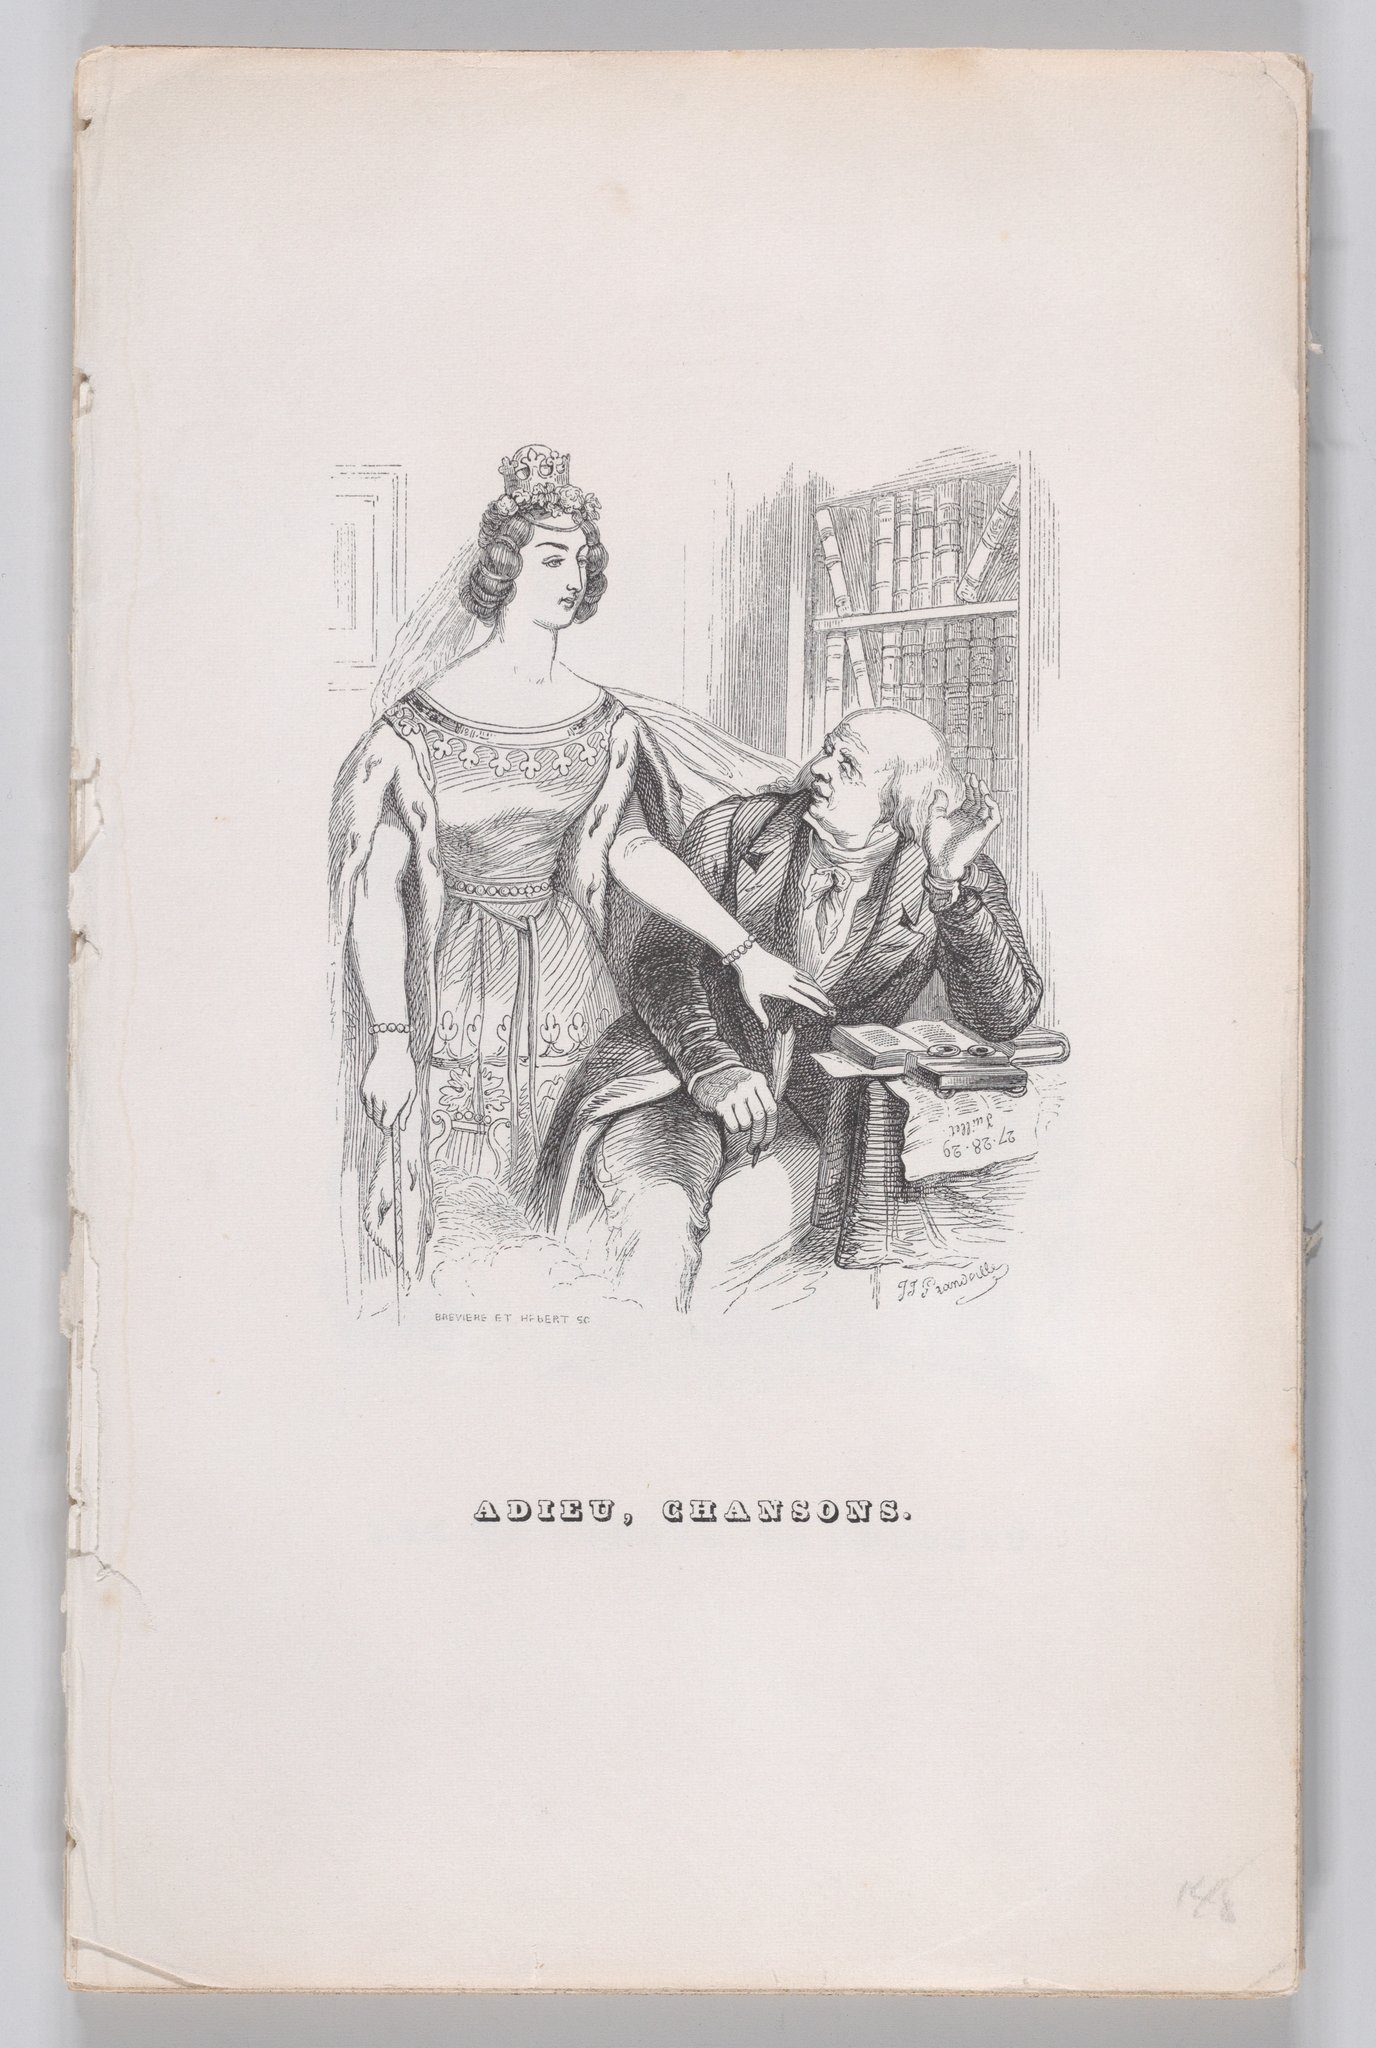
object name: print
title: Goodbye, Chansons, from "The Complete Works of Béranger"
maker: j. j. grandville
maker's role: illustrator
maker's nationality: french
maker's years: 1803-1847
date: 1836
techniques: engraving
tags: men,women